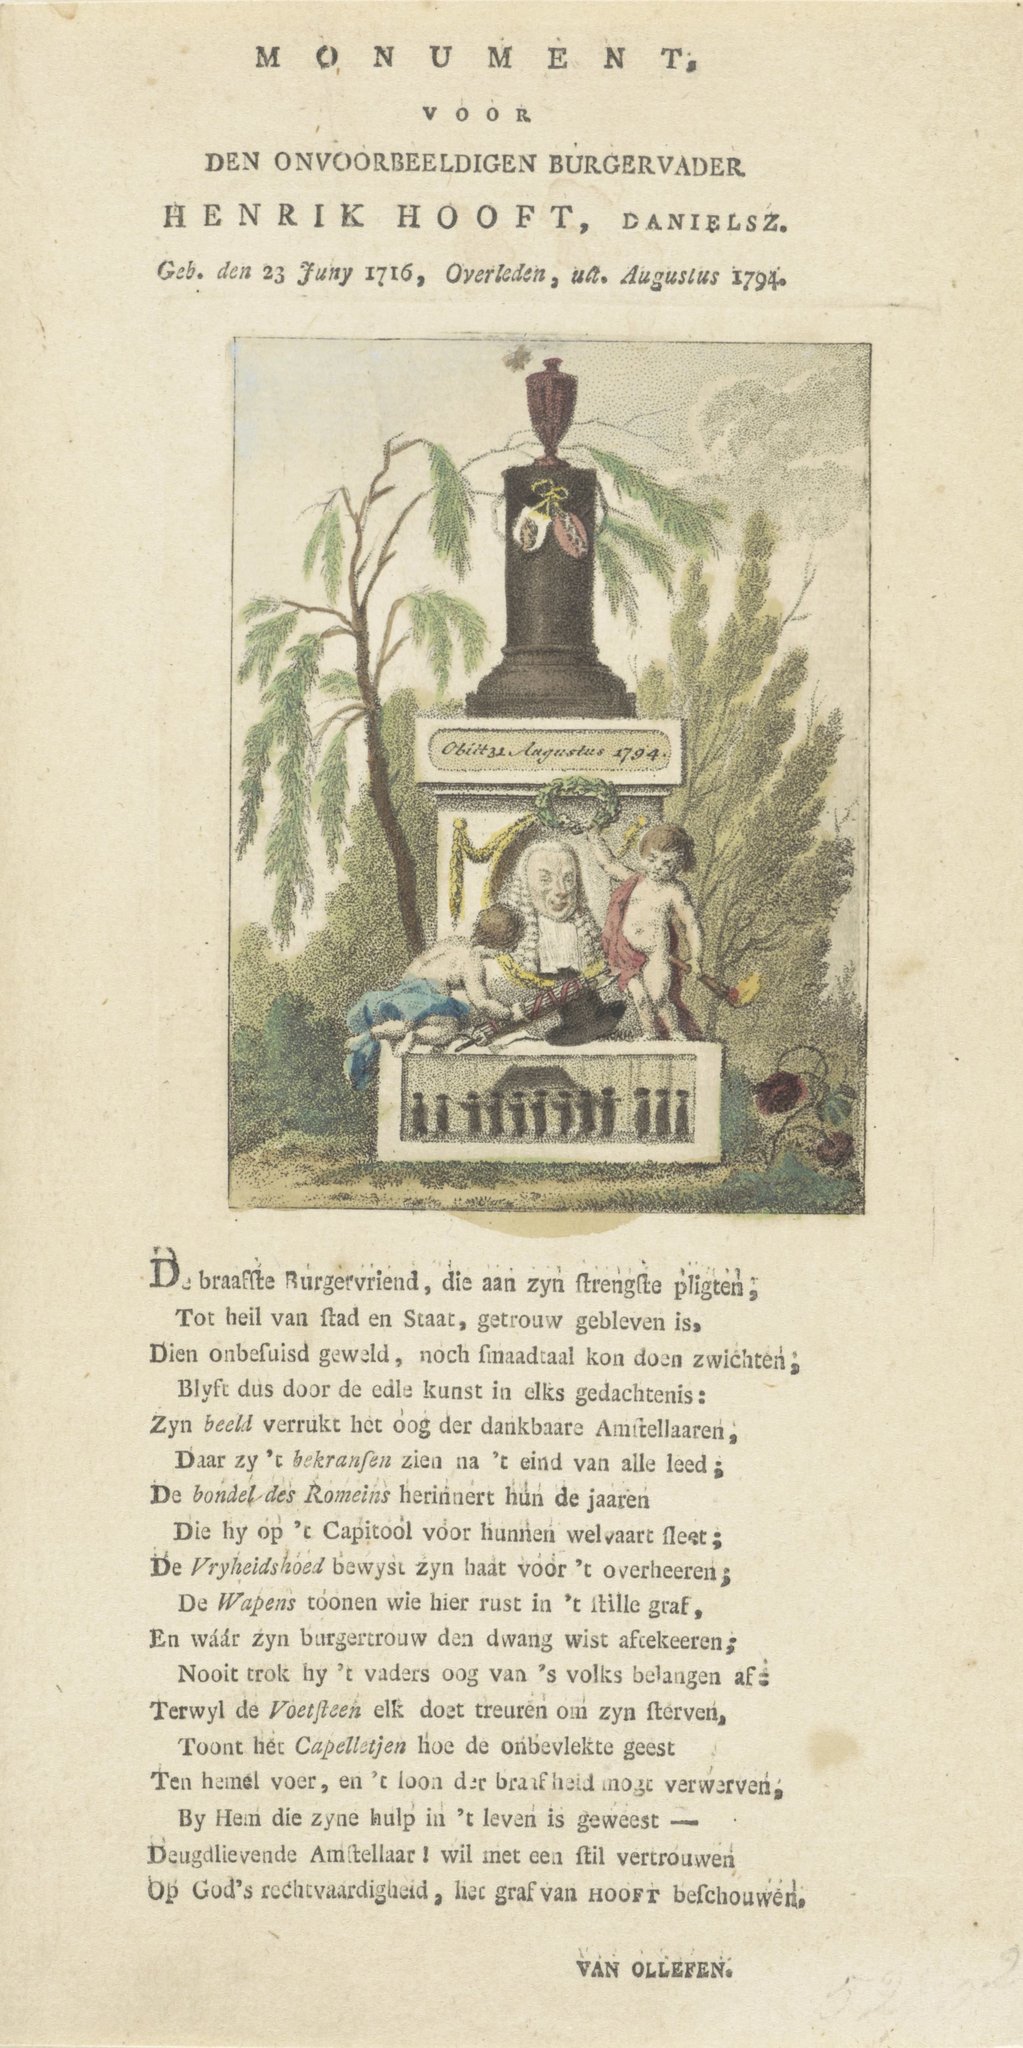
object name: print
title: Gedenkzuil voor Hendrik Danielsz. Hooft, 1794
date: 1794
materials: paper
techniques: hand coloring, letterpress printing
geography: northern netherlands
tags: amsterdam, mayor, hendrik danielsz. hooft, grave-building, monumental tomb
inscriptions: collector's mark: Lugt 2228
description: Allegorisch gedenkzuil voor Hendrik Danielsz. Hooft, oud-burgemeester van Amsterdam, overleden op 31 augustus 1794. Twee putti bij een zuil met portret van Hooft. Op het blad onder de plaat een vers van achttien regels.